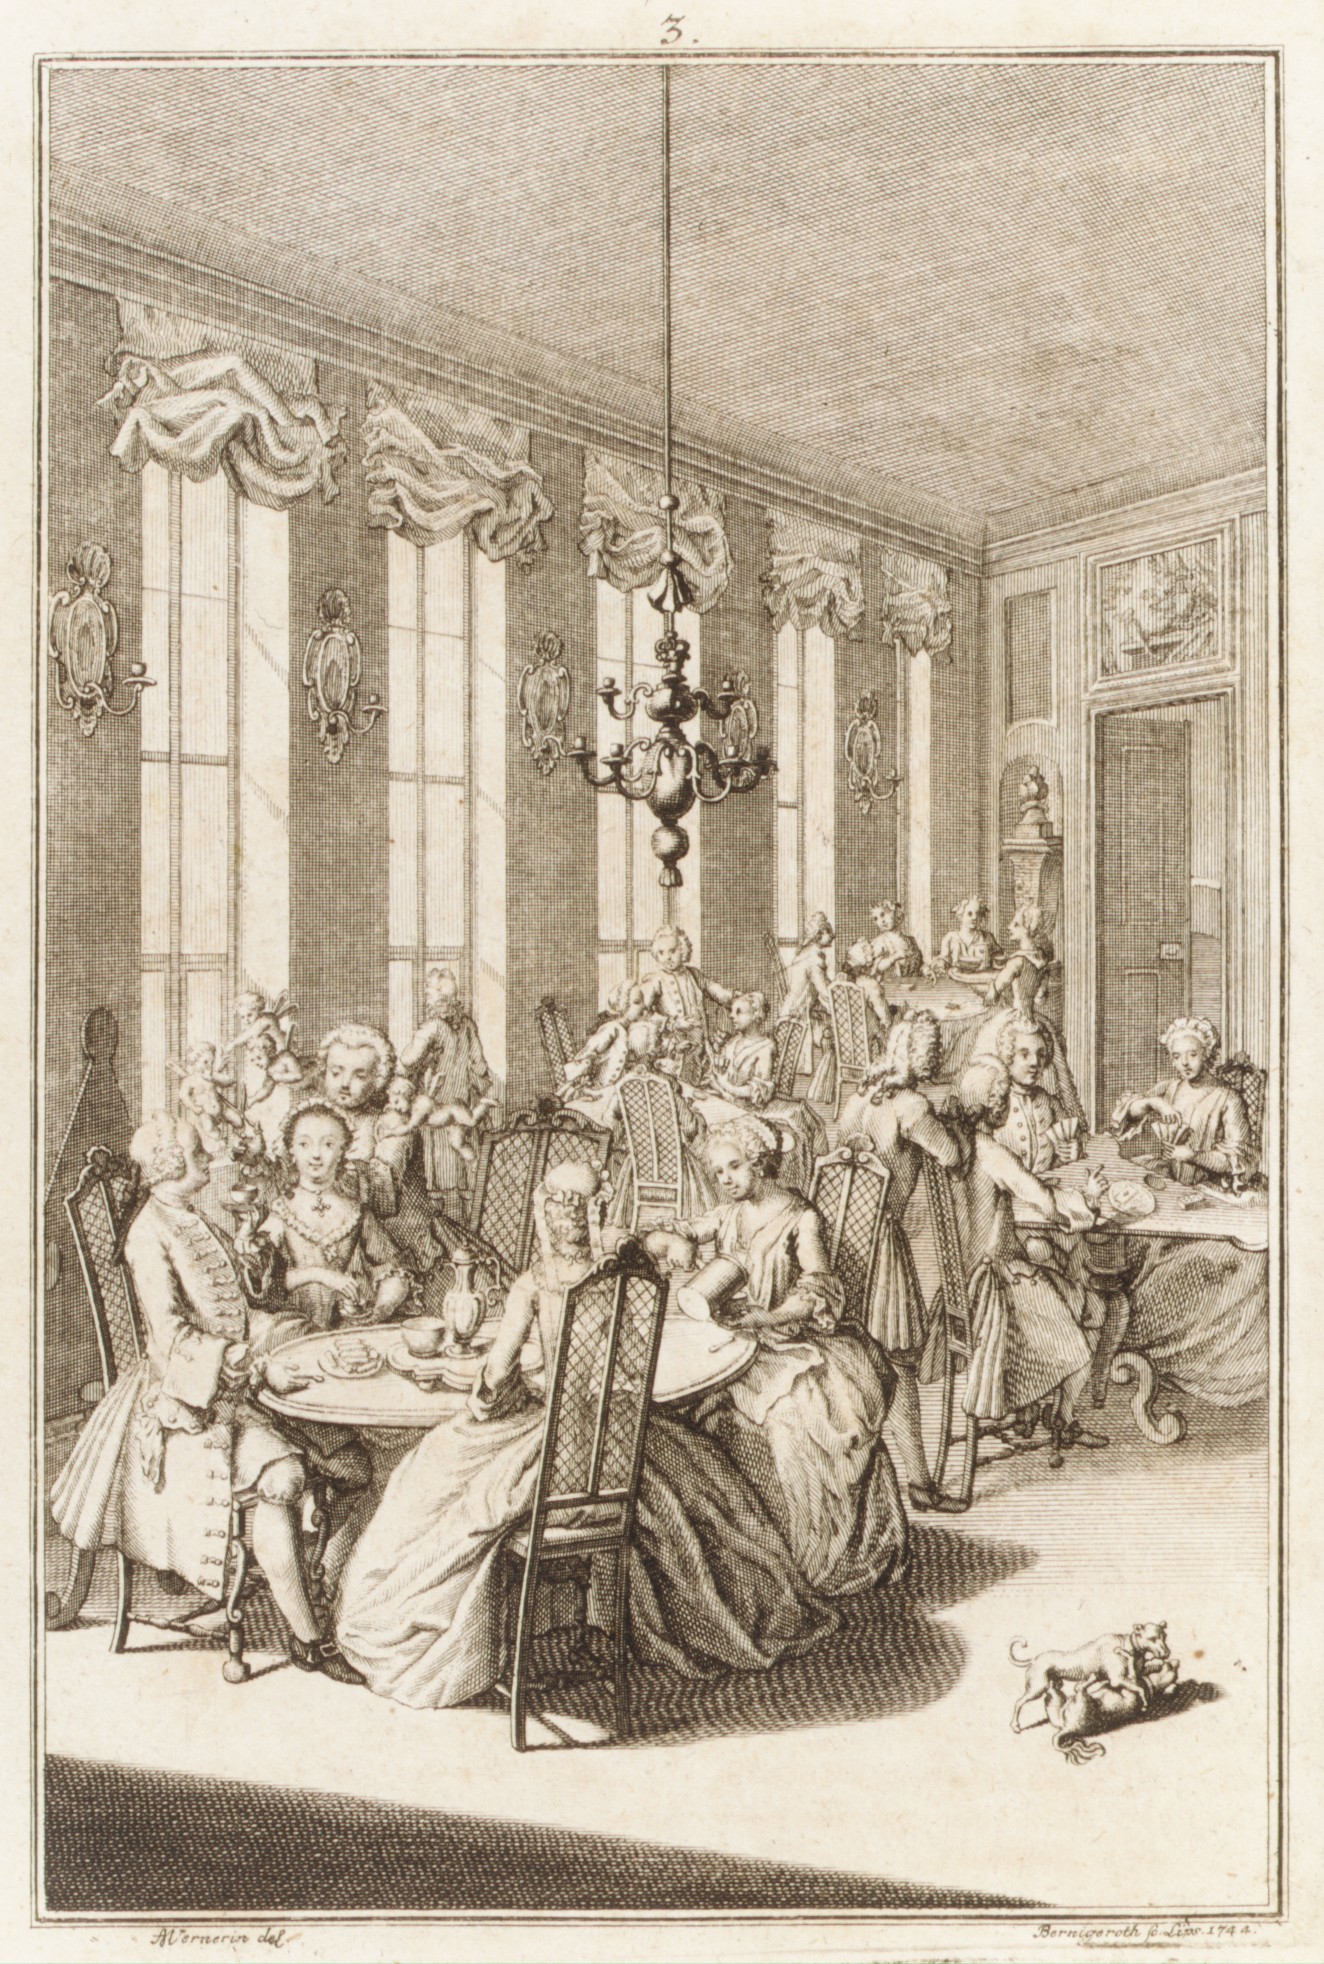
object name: book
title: Der Lockenraub, ein scherzhaftes Heldengedicht.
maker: alexander pope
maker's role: author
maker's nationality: british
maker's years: 1688-1744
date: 1772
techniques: engraving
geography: germany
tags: men,women,dogs,chairs,tables